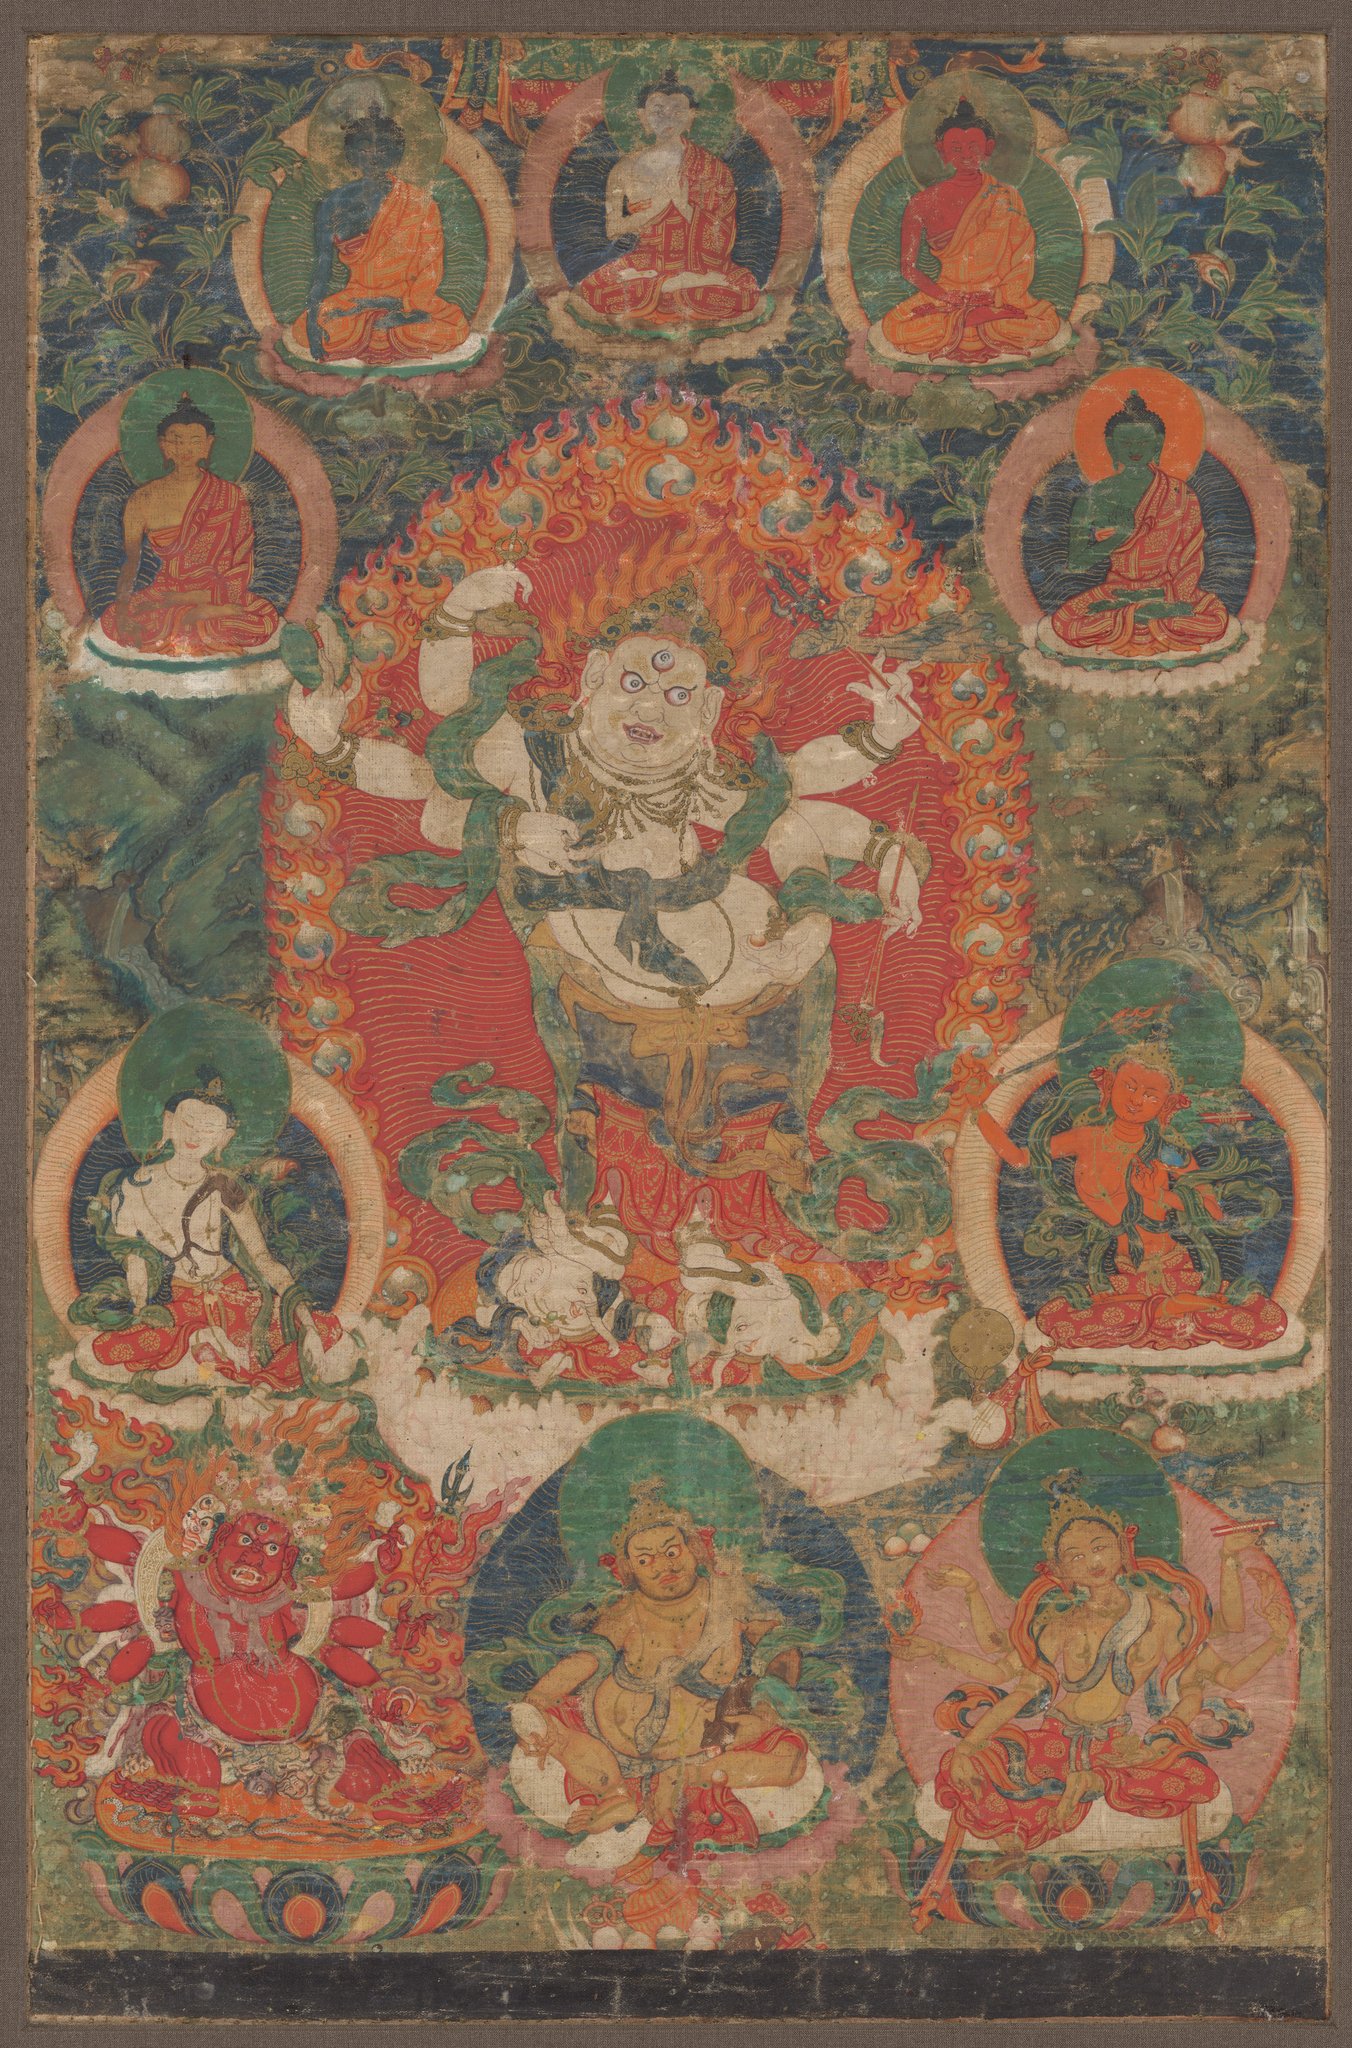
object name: thangka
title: White Mahakala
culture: tibetan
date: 1701-1800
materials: cotton